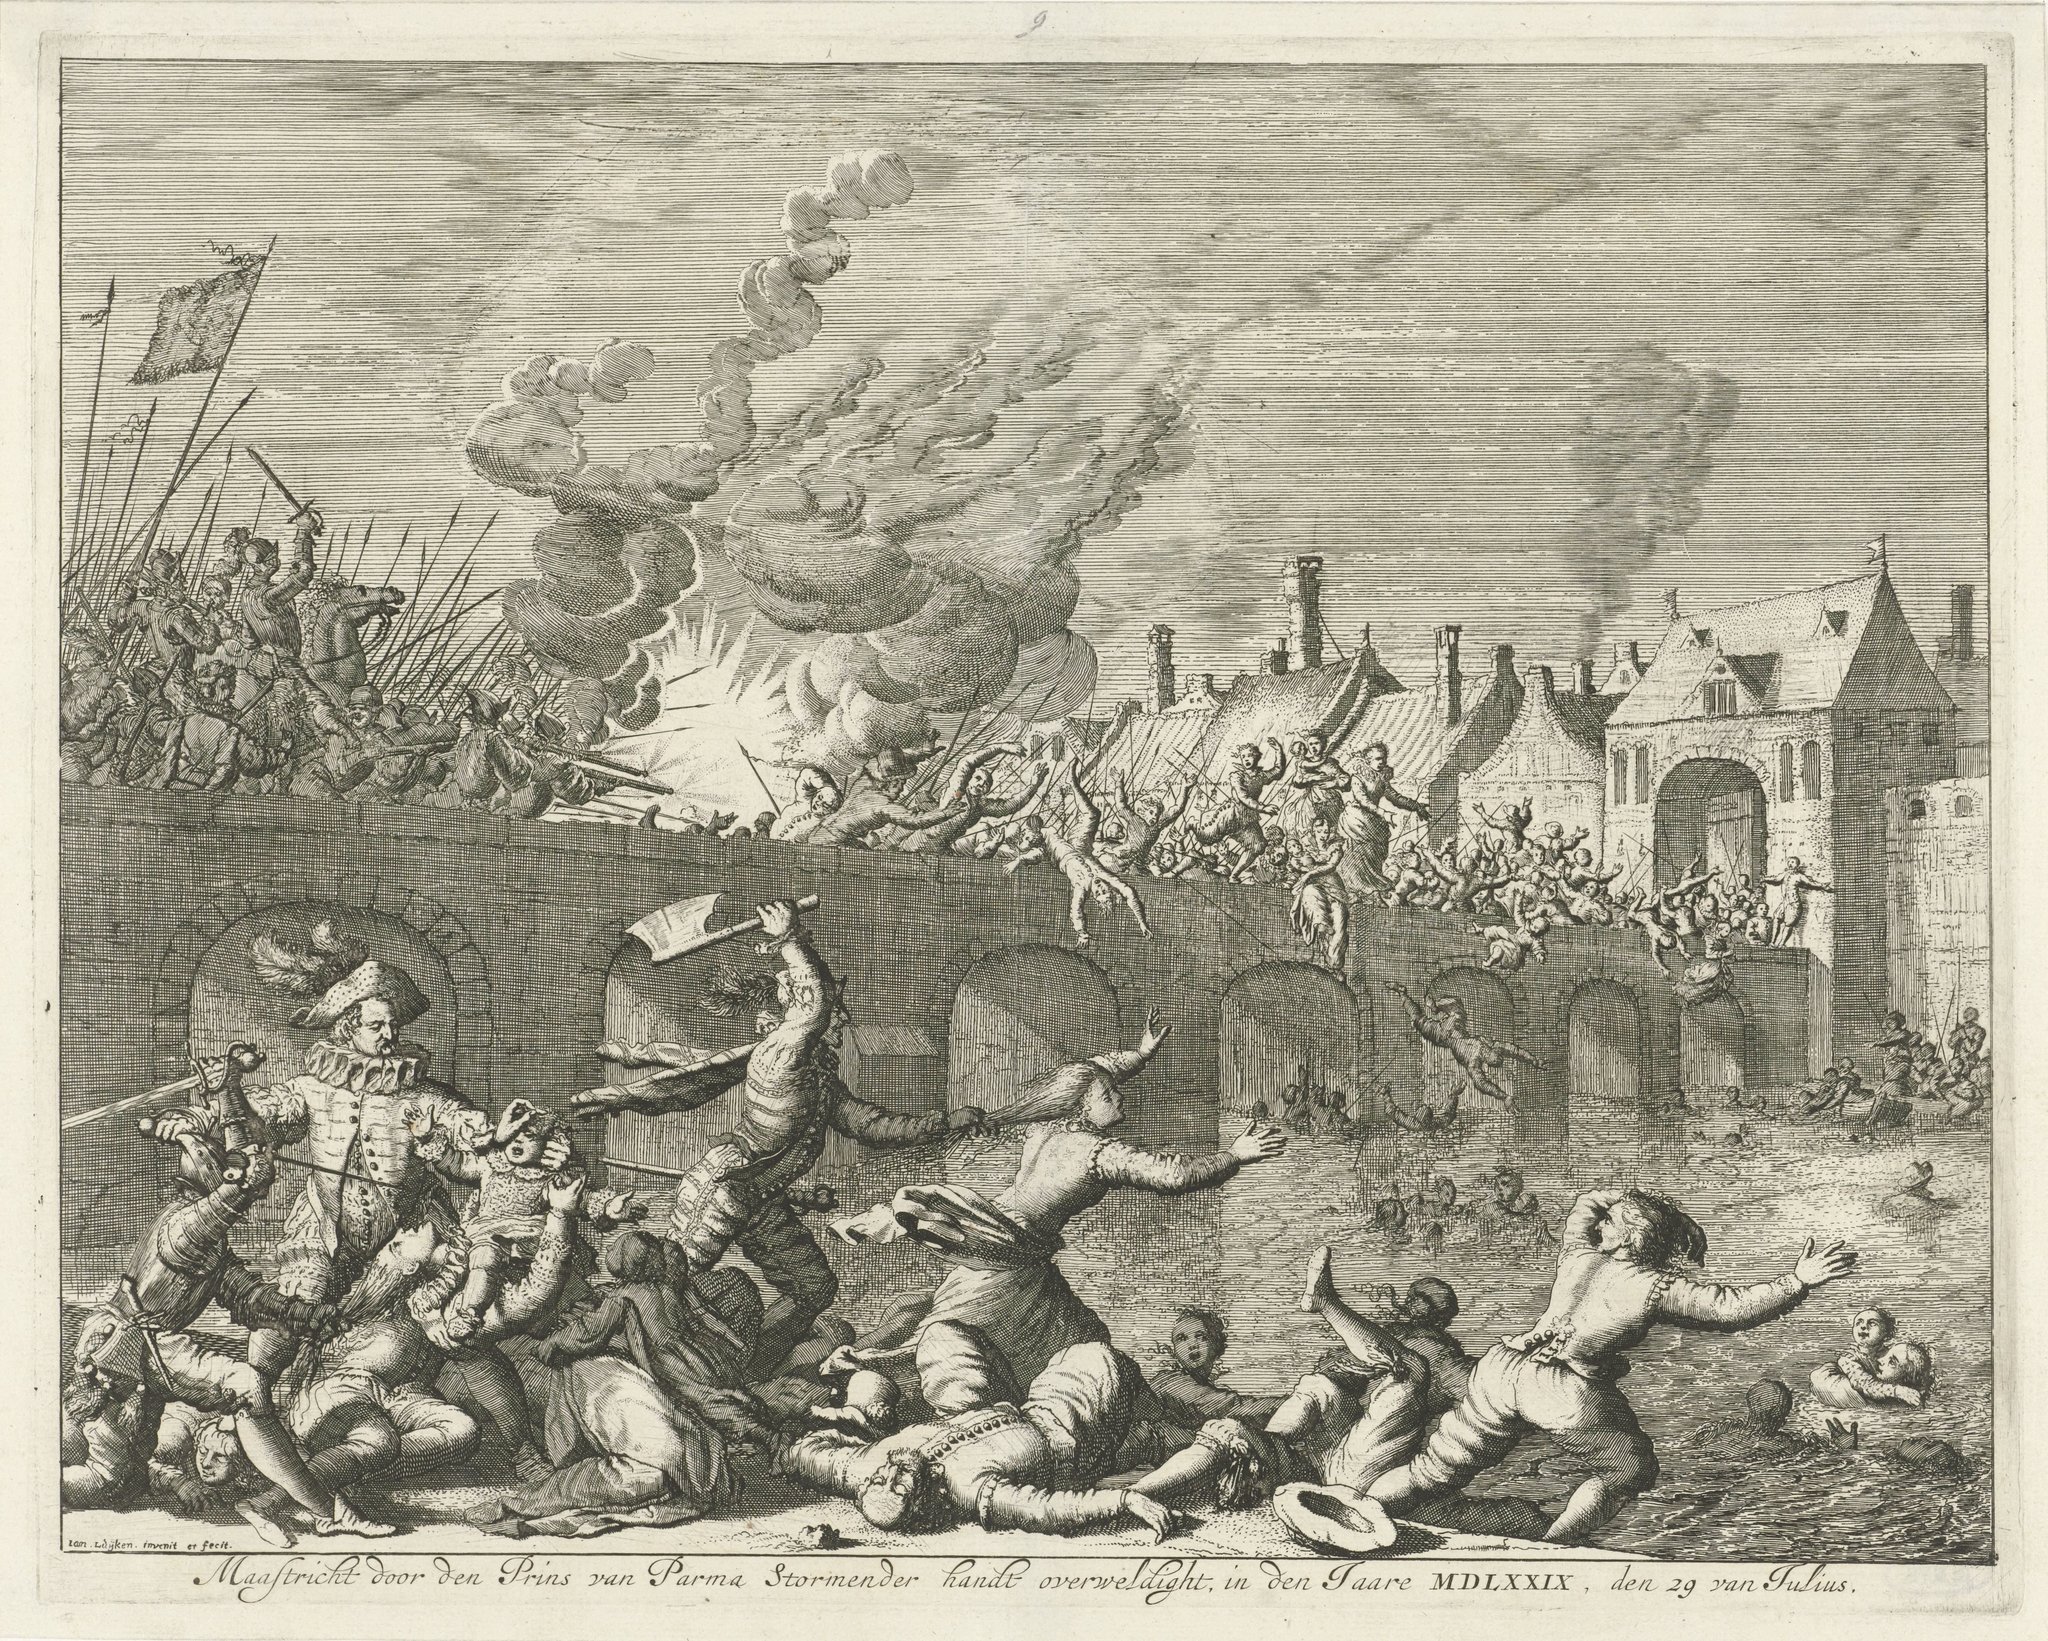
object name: print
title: Maastricht door den Prins van Parma Stormender handt overweldight, in den Jaare MDLXXIX, den 29 van Julius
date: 1678-1680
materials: paper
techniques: engraving, etching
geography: amsterdam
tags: massacre ~ war, maastricht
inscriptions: collector's mark: Lugt 2228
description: Illustratie gebruikt in: Bor Christiaansz, Pieter. Oorsprongk, begin, en vervolgh der Nederlandsche oorlogen, 4 delen. Amsterdam: weduwe Joannes van Someren, Abraham Wolfgang, Hendrick en Dirk Boom, 1679-1684, dl. II, p. 65.